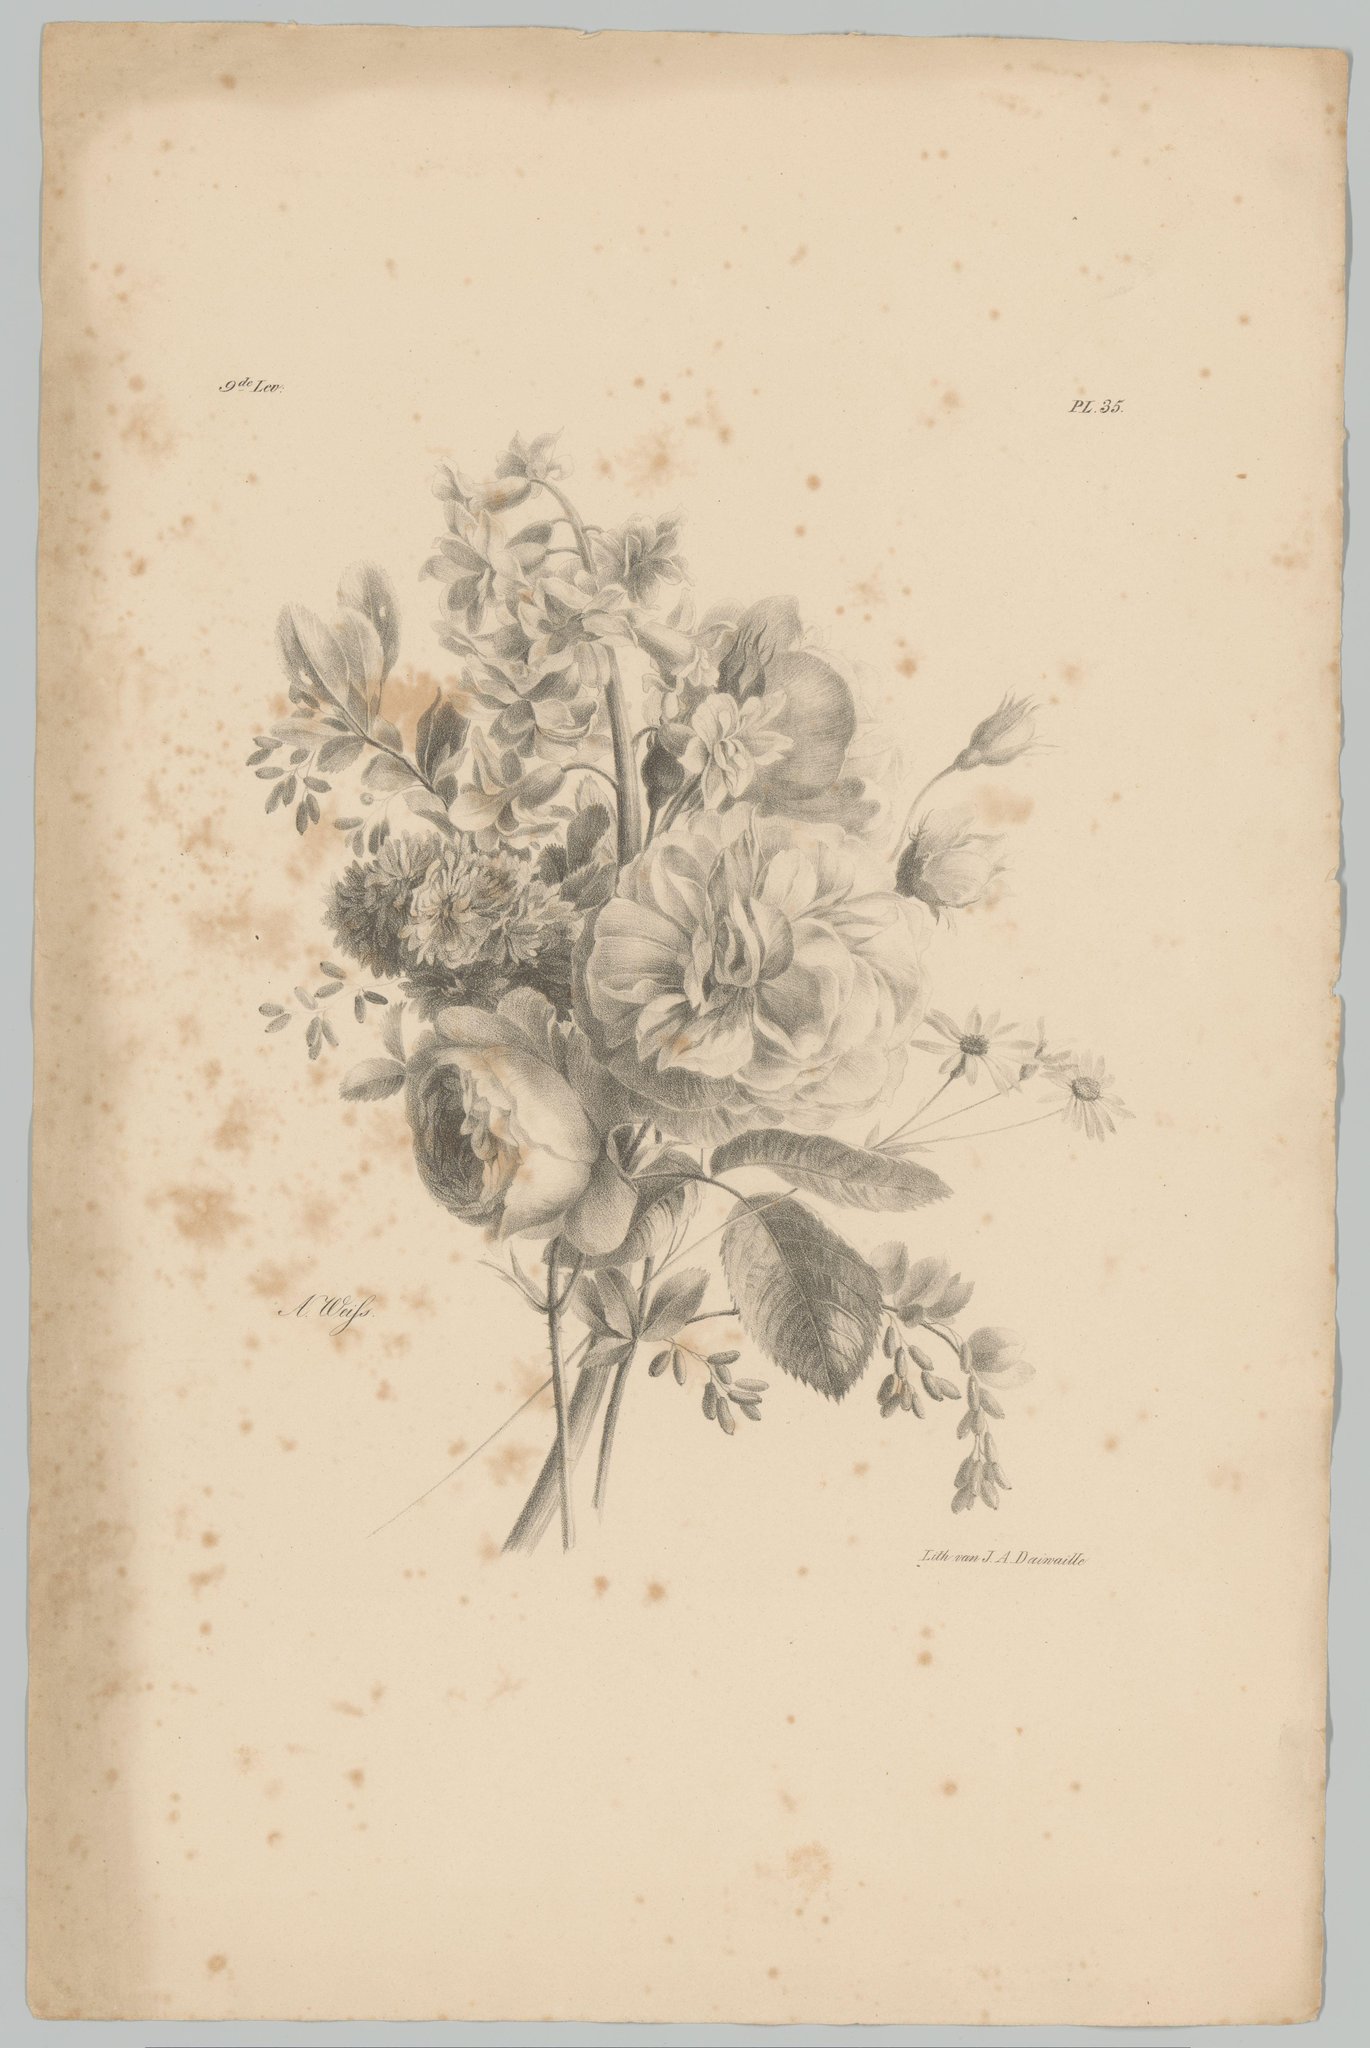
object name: print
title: Diverse bloemen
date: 1820-1833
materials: paper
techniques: lithograph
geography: amsterdam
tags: flowers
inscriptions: collector's mark: Lugt 2228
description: Links boven genummerd 9de Lev. Onderdeel van een omslag met in totaal zevenenzeventig lithografieën van bloemen en fruit.